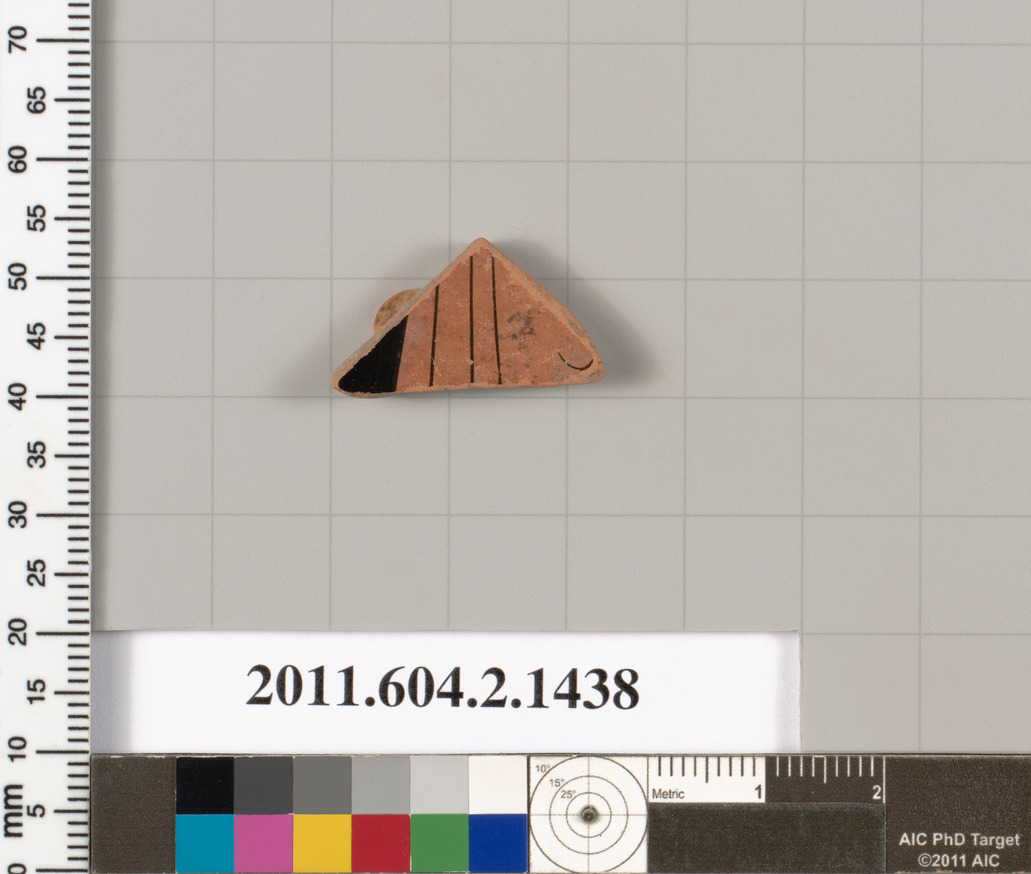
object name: skyphos fragment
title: Terracotta fragment of a skyphos (deep drinking cup)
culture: greek, attic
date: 475-451 BCE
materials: terracotta